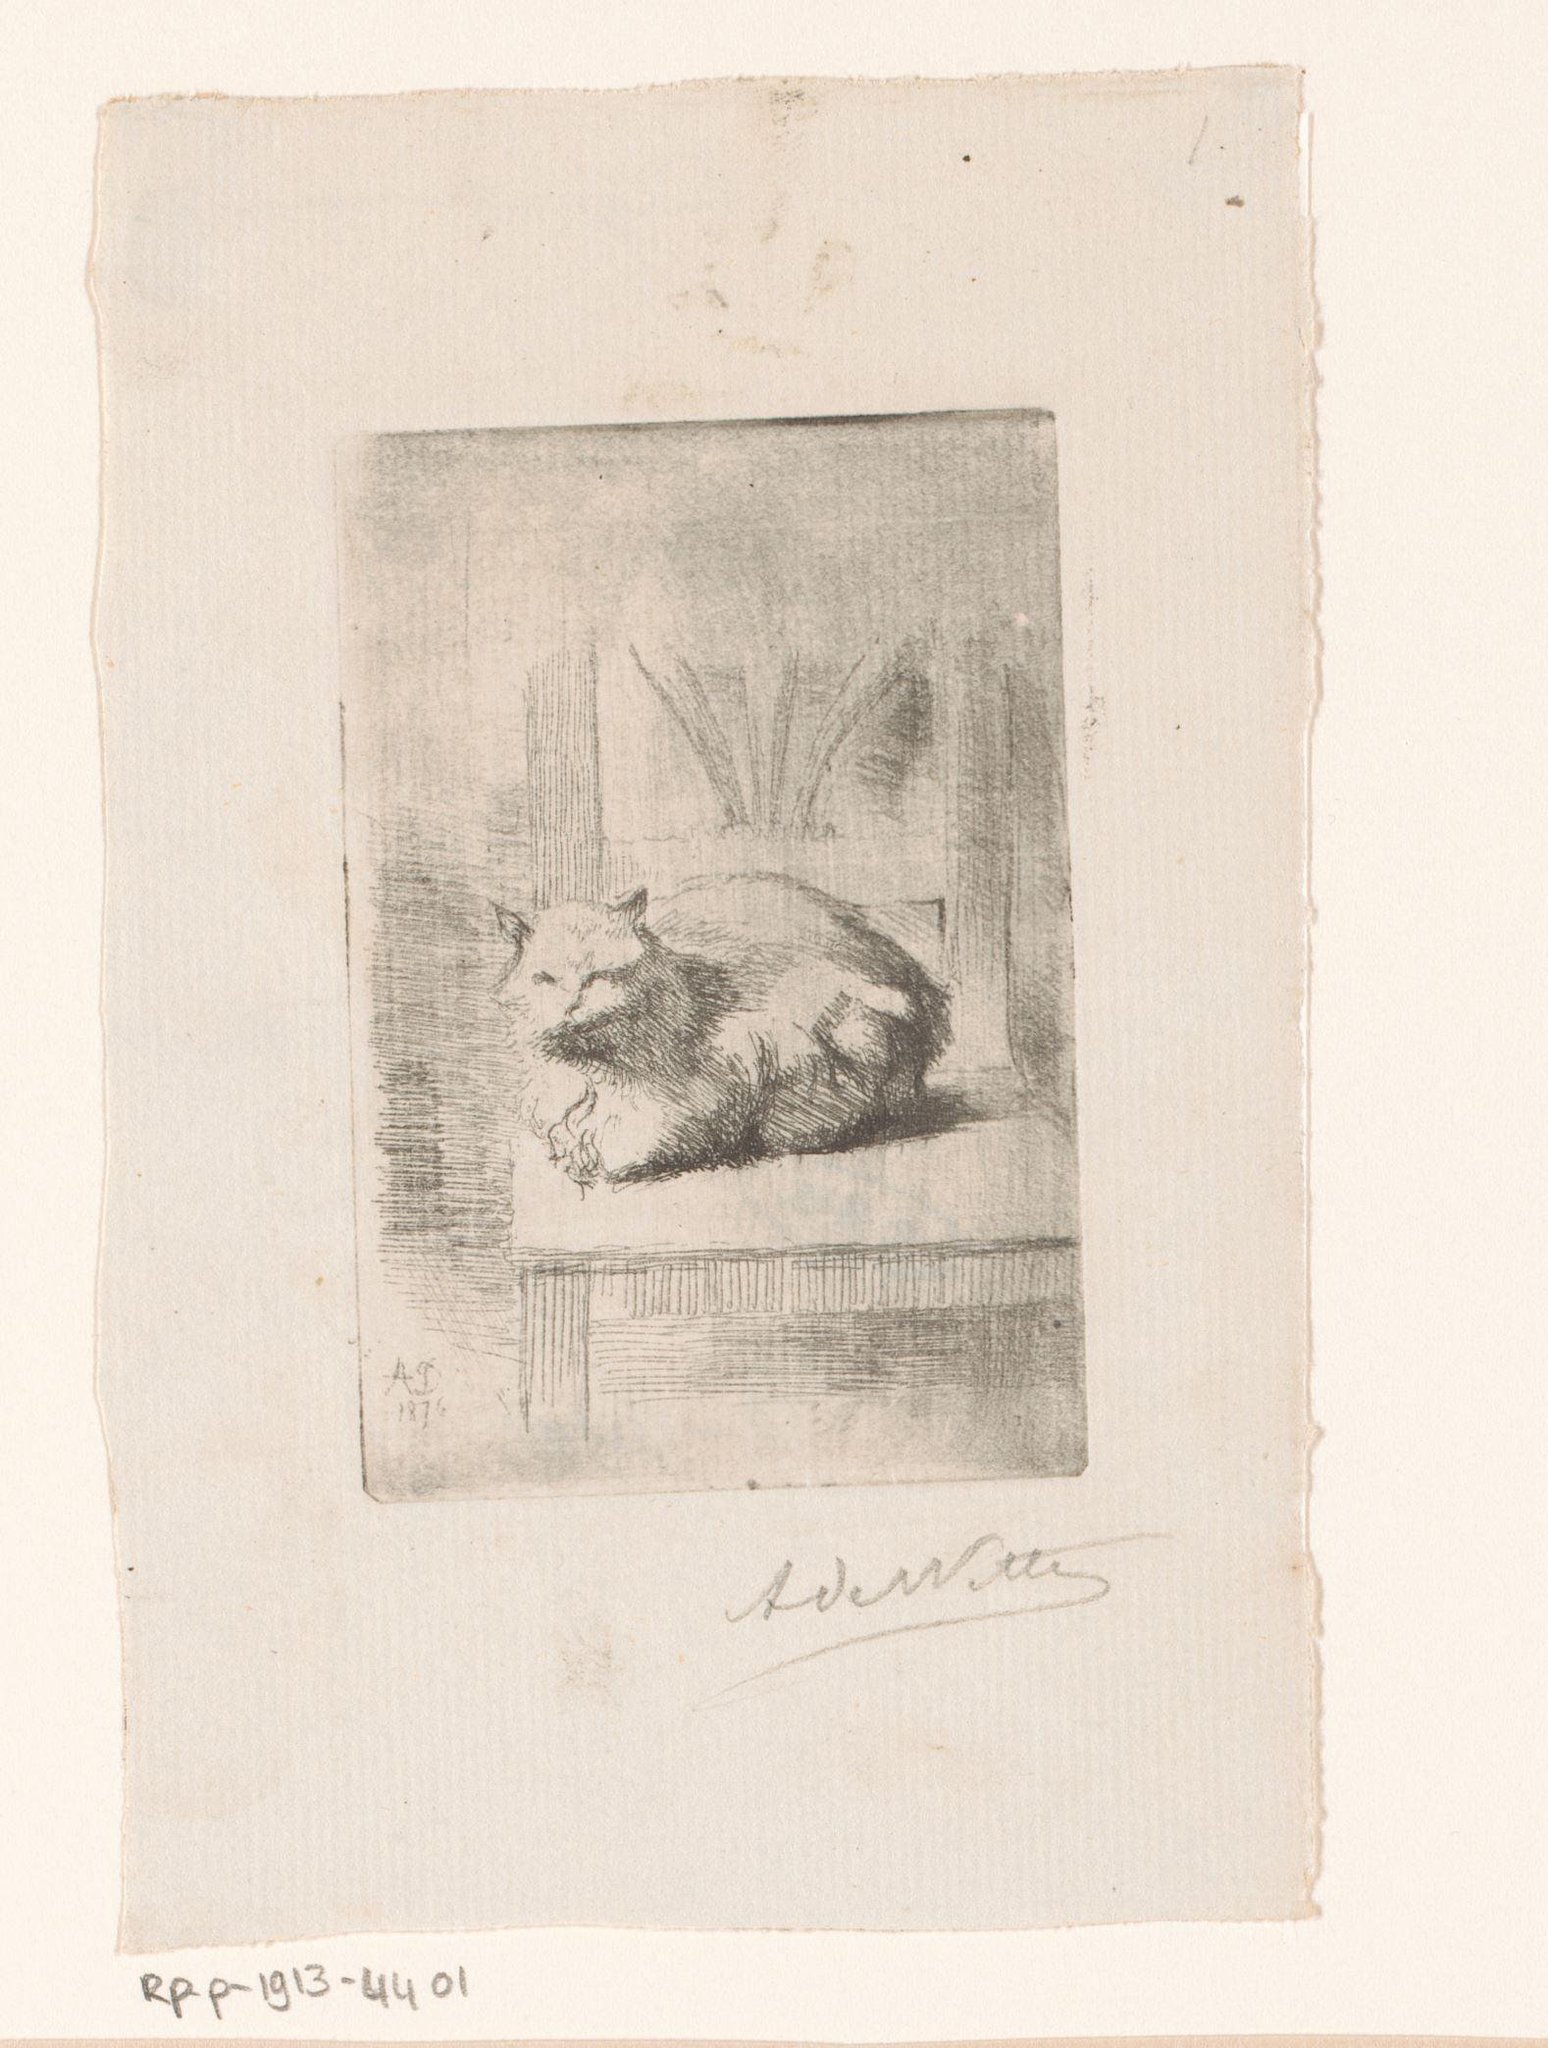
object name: print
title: Kat op een stoel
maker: adrien de witte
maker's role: print maker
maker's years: 1850-1935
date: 1876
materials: paper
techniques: drypoint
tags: cat, chair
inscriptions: collector's mark: Lugt 2228